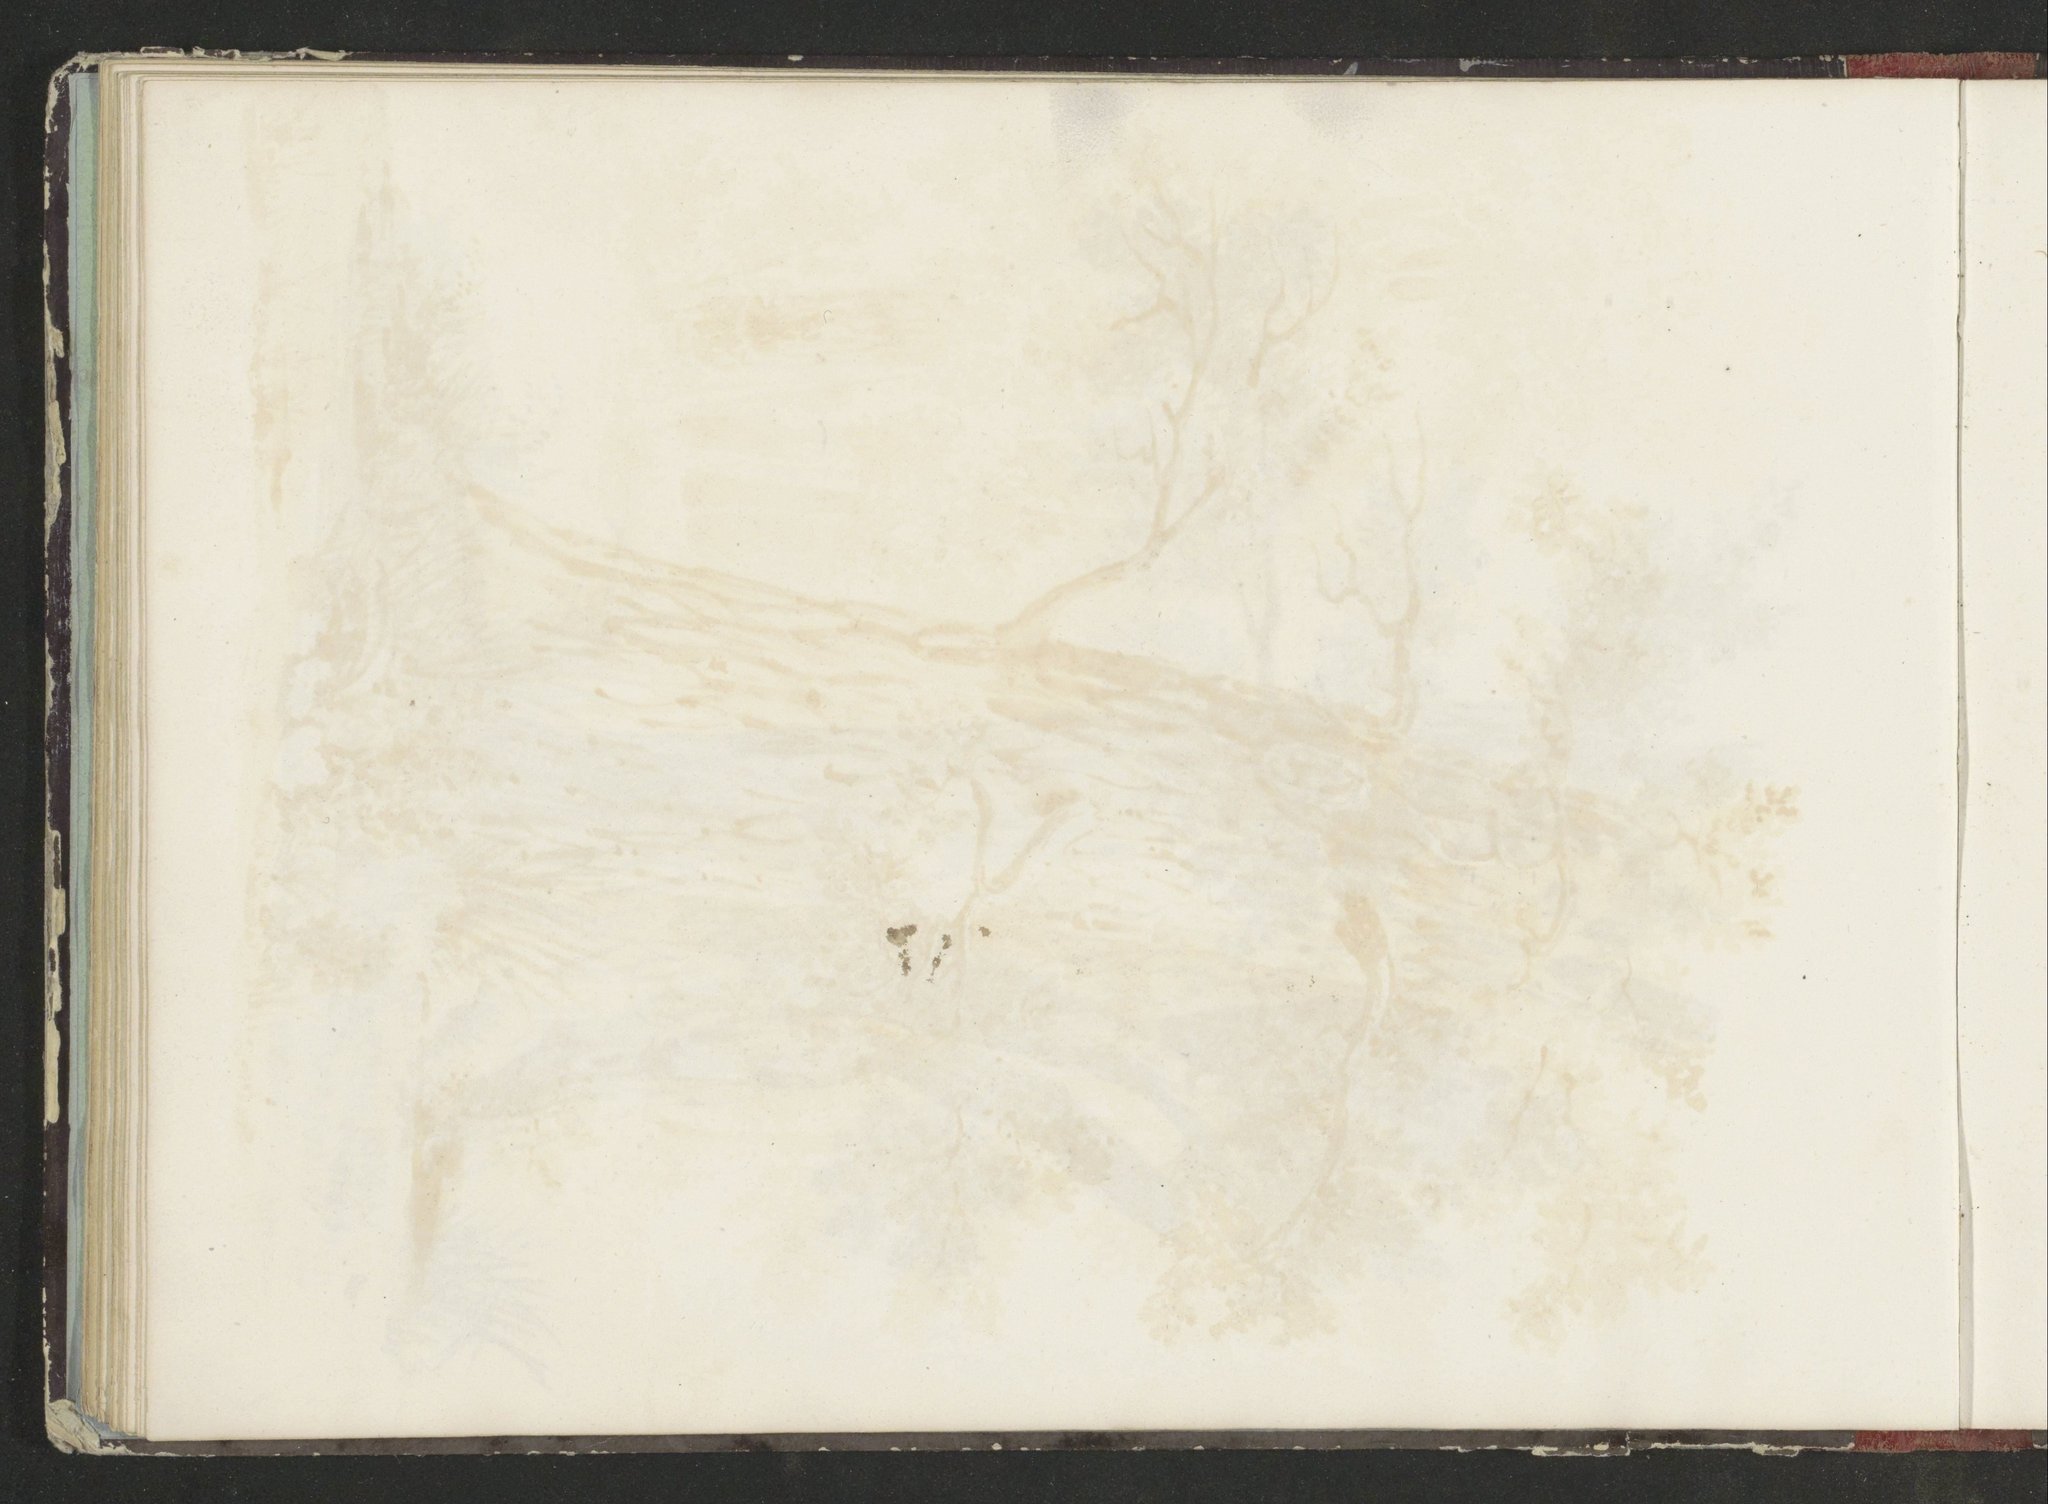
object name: sketchbook leaf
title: Abklatsch van de tekening op blad 20 recto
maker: Anonymous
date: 1819-1870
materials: paper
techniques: printmaking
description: Blad 19 verso uit een schetsboek met 39 bladen.